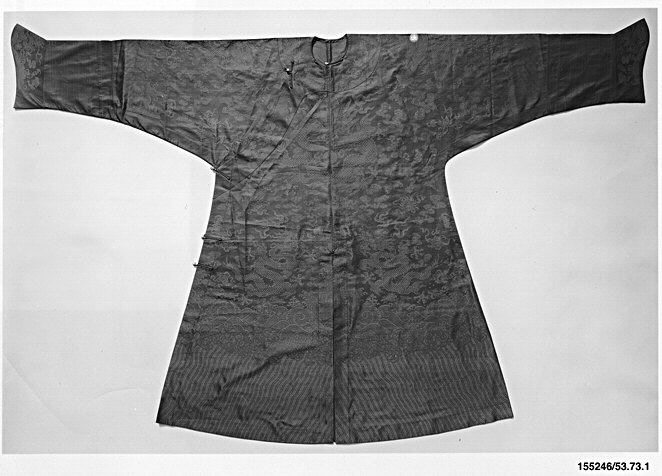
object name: man's court robe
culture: chinese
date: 1867-1933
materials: silk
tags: dragons